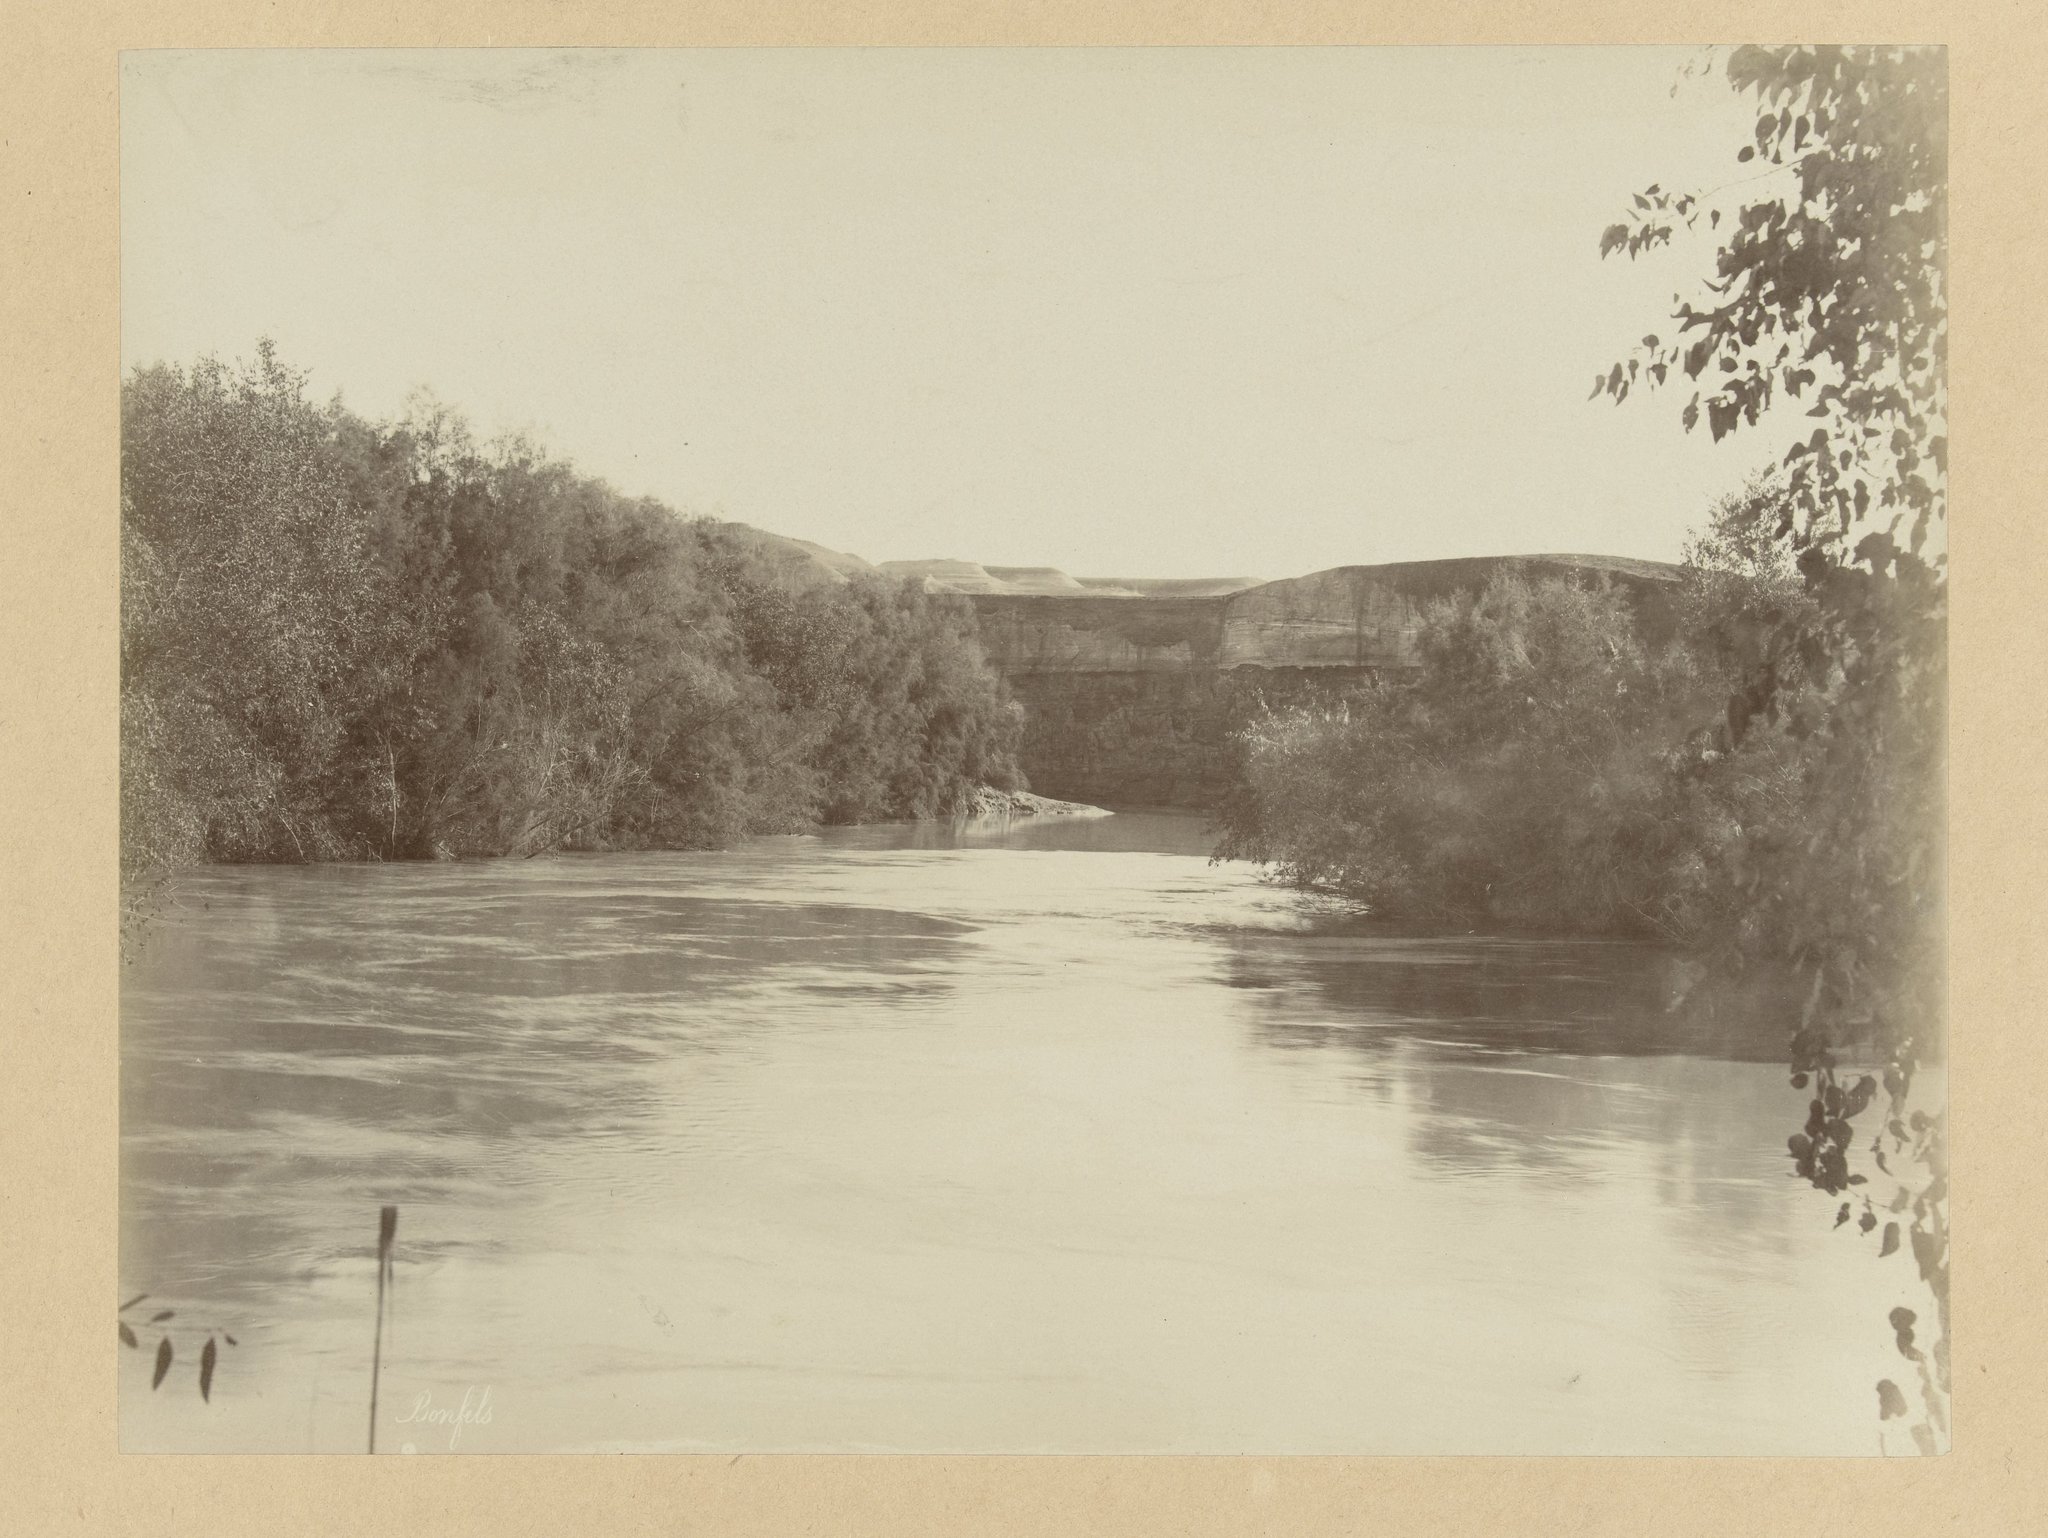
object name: photograph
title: Gezicht op de rivier de Jordaan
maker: félix bonfils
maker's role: fotograaf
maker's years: 1831-1885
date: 1867-1877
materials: cardboard, paper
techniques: albumen print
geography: ottoman empire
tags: river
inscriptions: stamp: ‘Gemeentelijke bibliotheek/ Rotterdam’, title: ‘S 61. De Jordaan. Syrië.’, check stamp: ‘Bristol/ L.M.’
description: Onderdeel van een groep door fotograaf Richard Polak op reis verzamelde foto’s. Deze foto is samen met andere op zijn reizen verzamelde foto's tentoongesteld bij de Rotterdamsche Kunstkring (1895), Arti en Amicitiae te Amsterdam (1897-1898?) en Societeit 't Collegie te Kampen (datum vooralsnog onbekend).